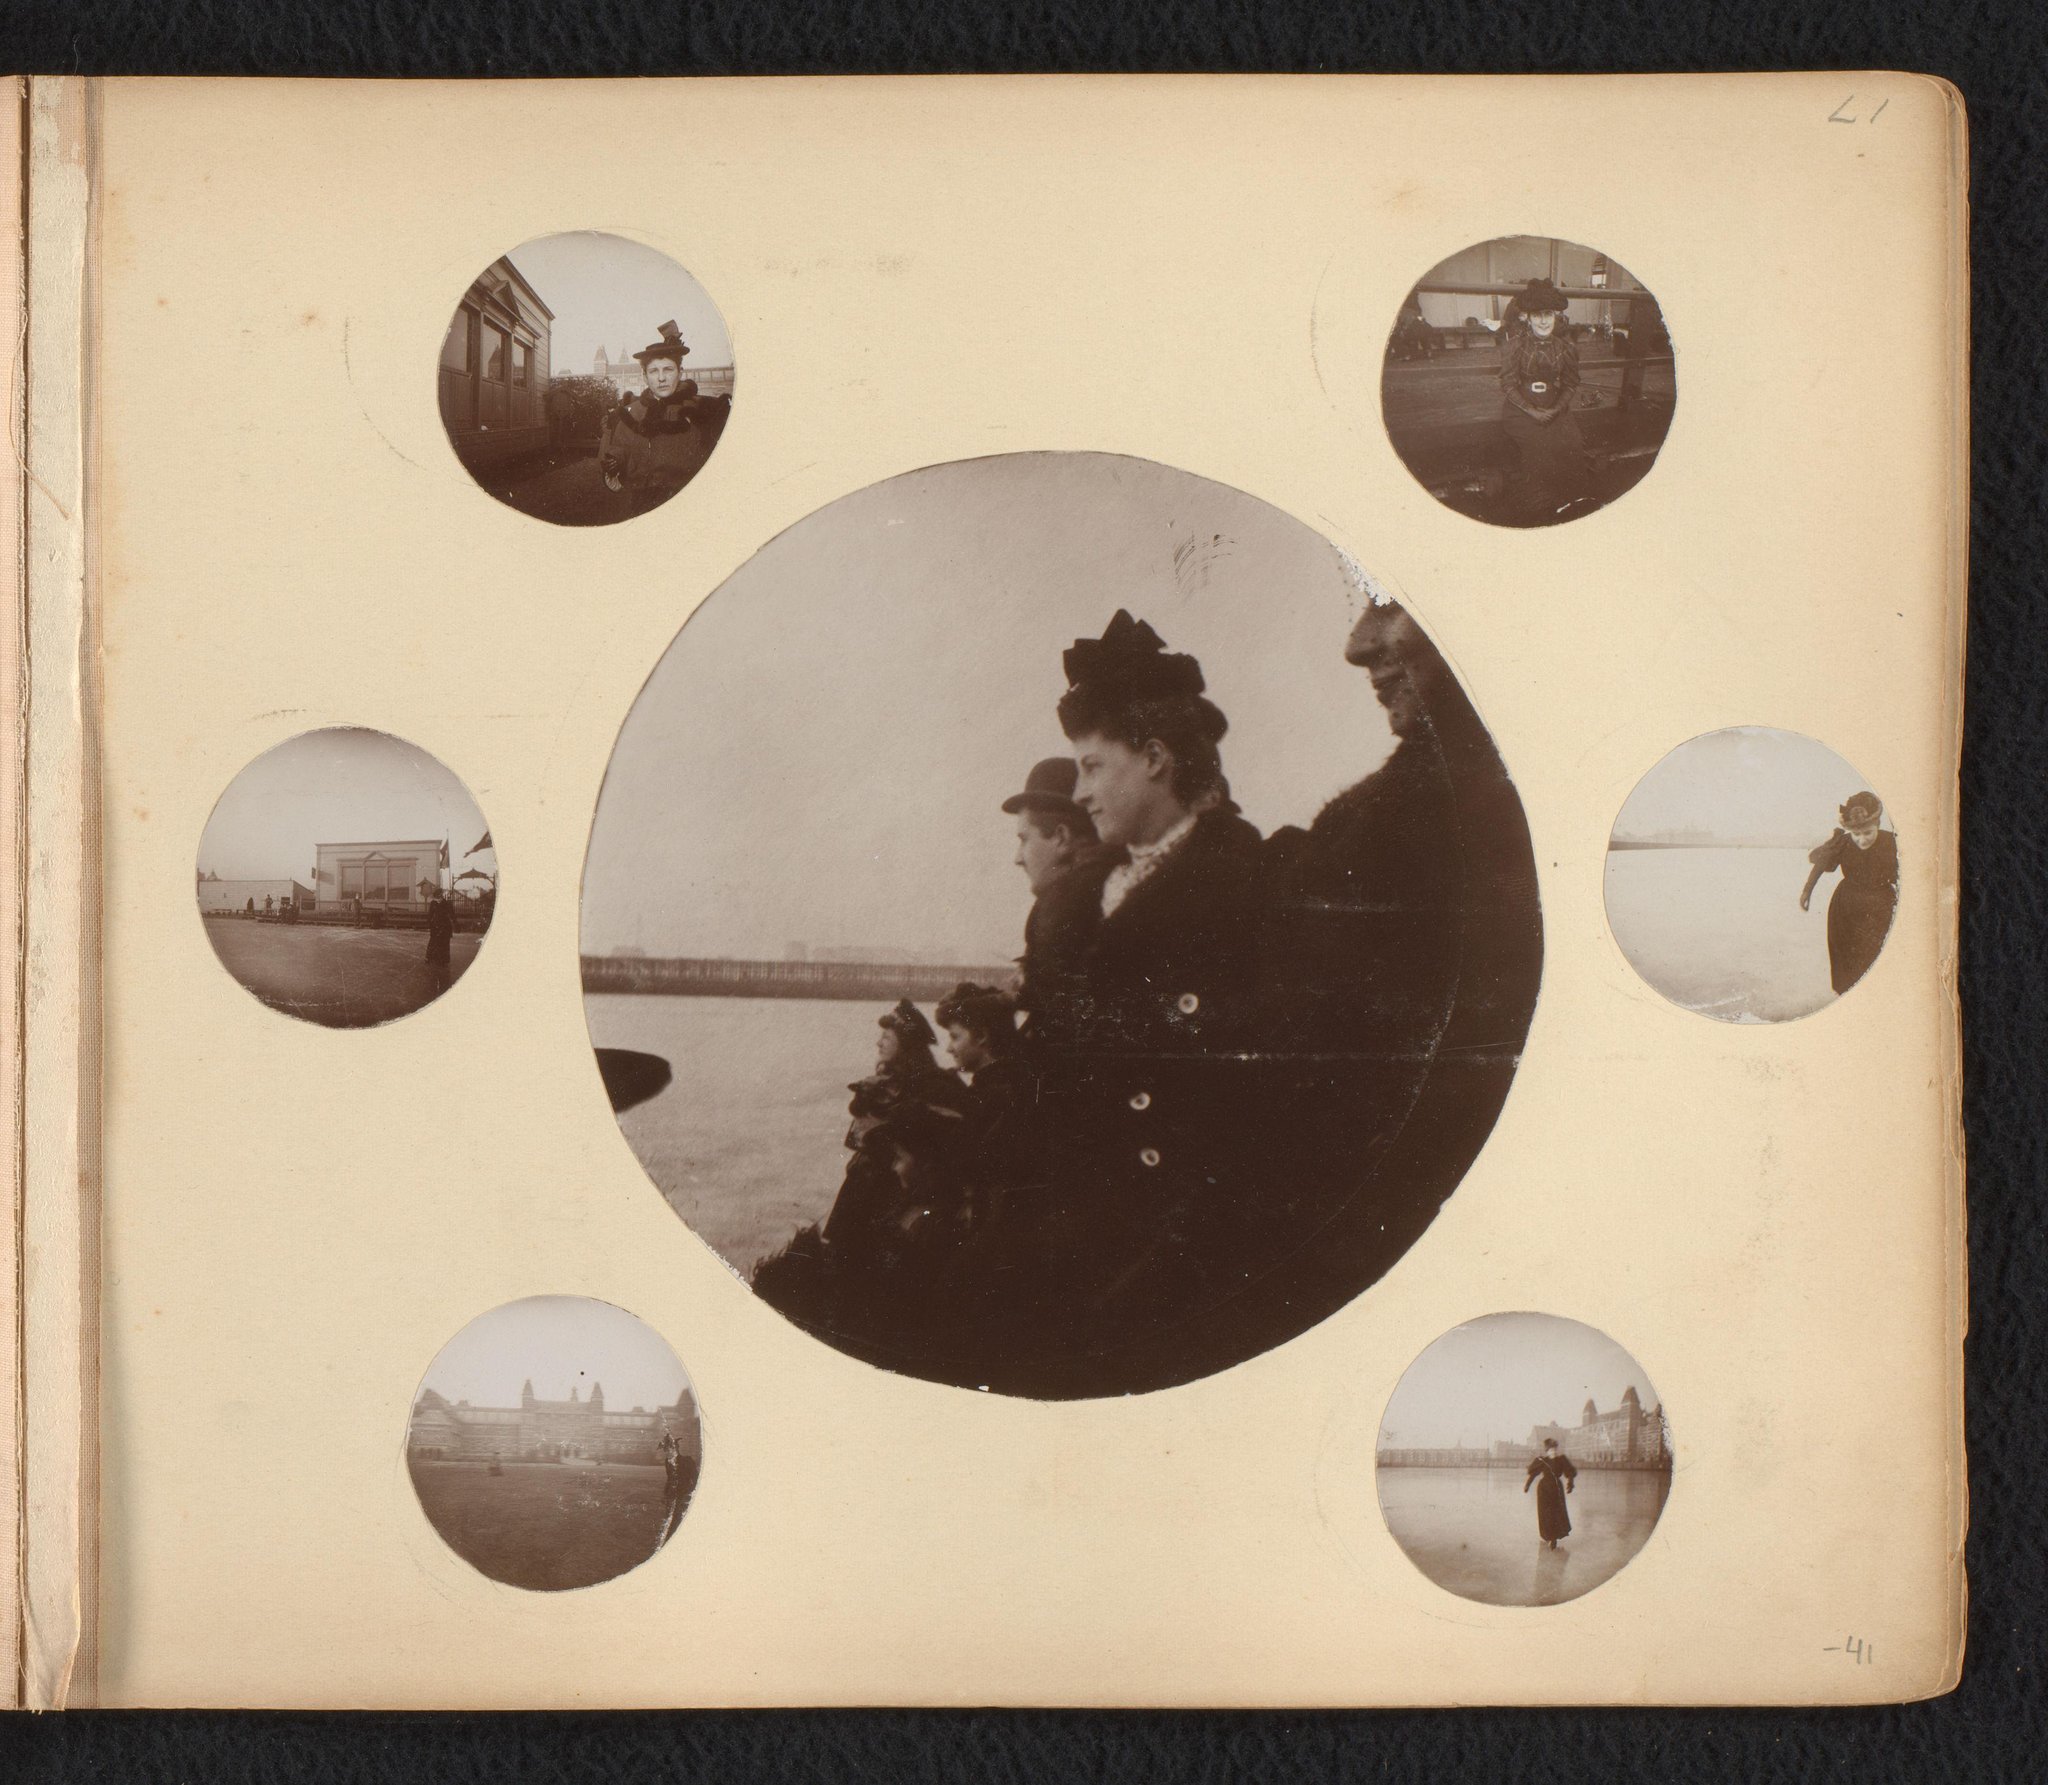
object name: photograph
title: Zeven ronde Kodak-foto's van schaatsers op het Museumplein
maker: hendrik herman van den berg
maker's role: amateurfotograaf, jurist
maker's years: 1875-1944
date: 1891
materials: paper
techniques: collodion silver print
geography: amsterdam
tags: square, place, circus, etc., historical persons, skates (winter sports)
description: Albumblad met zeven foto's "Schaatsen op het Museumplein" uit album "Amsterdam 1890-1894".